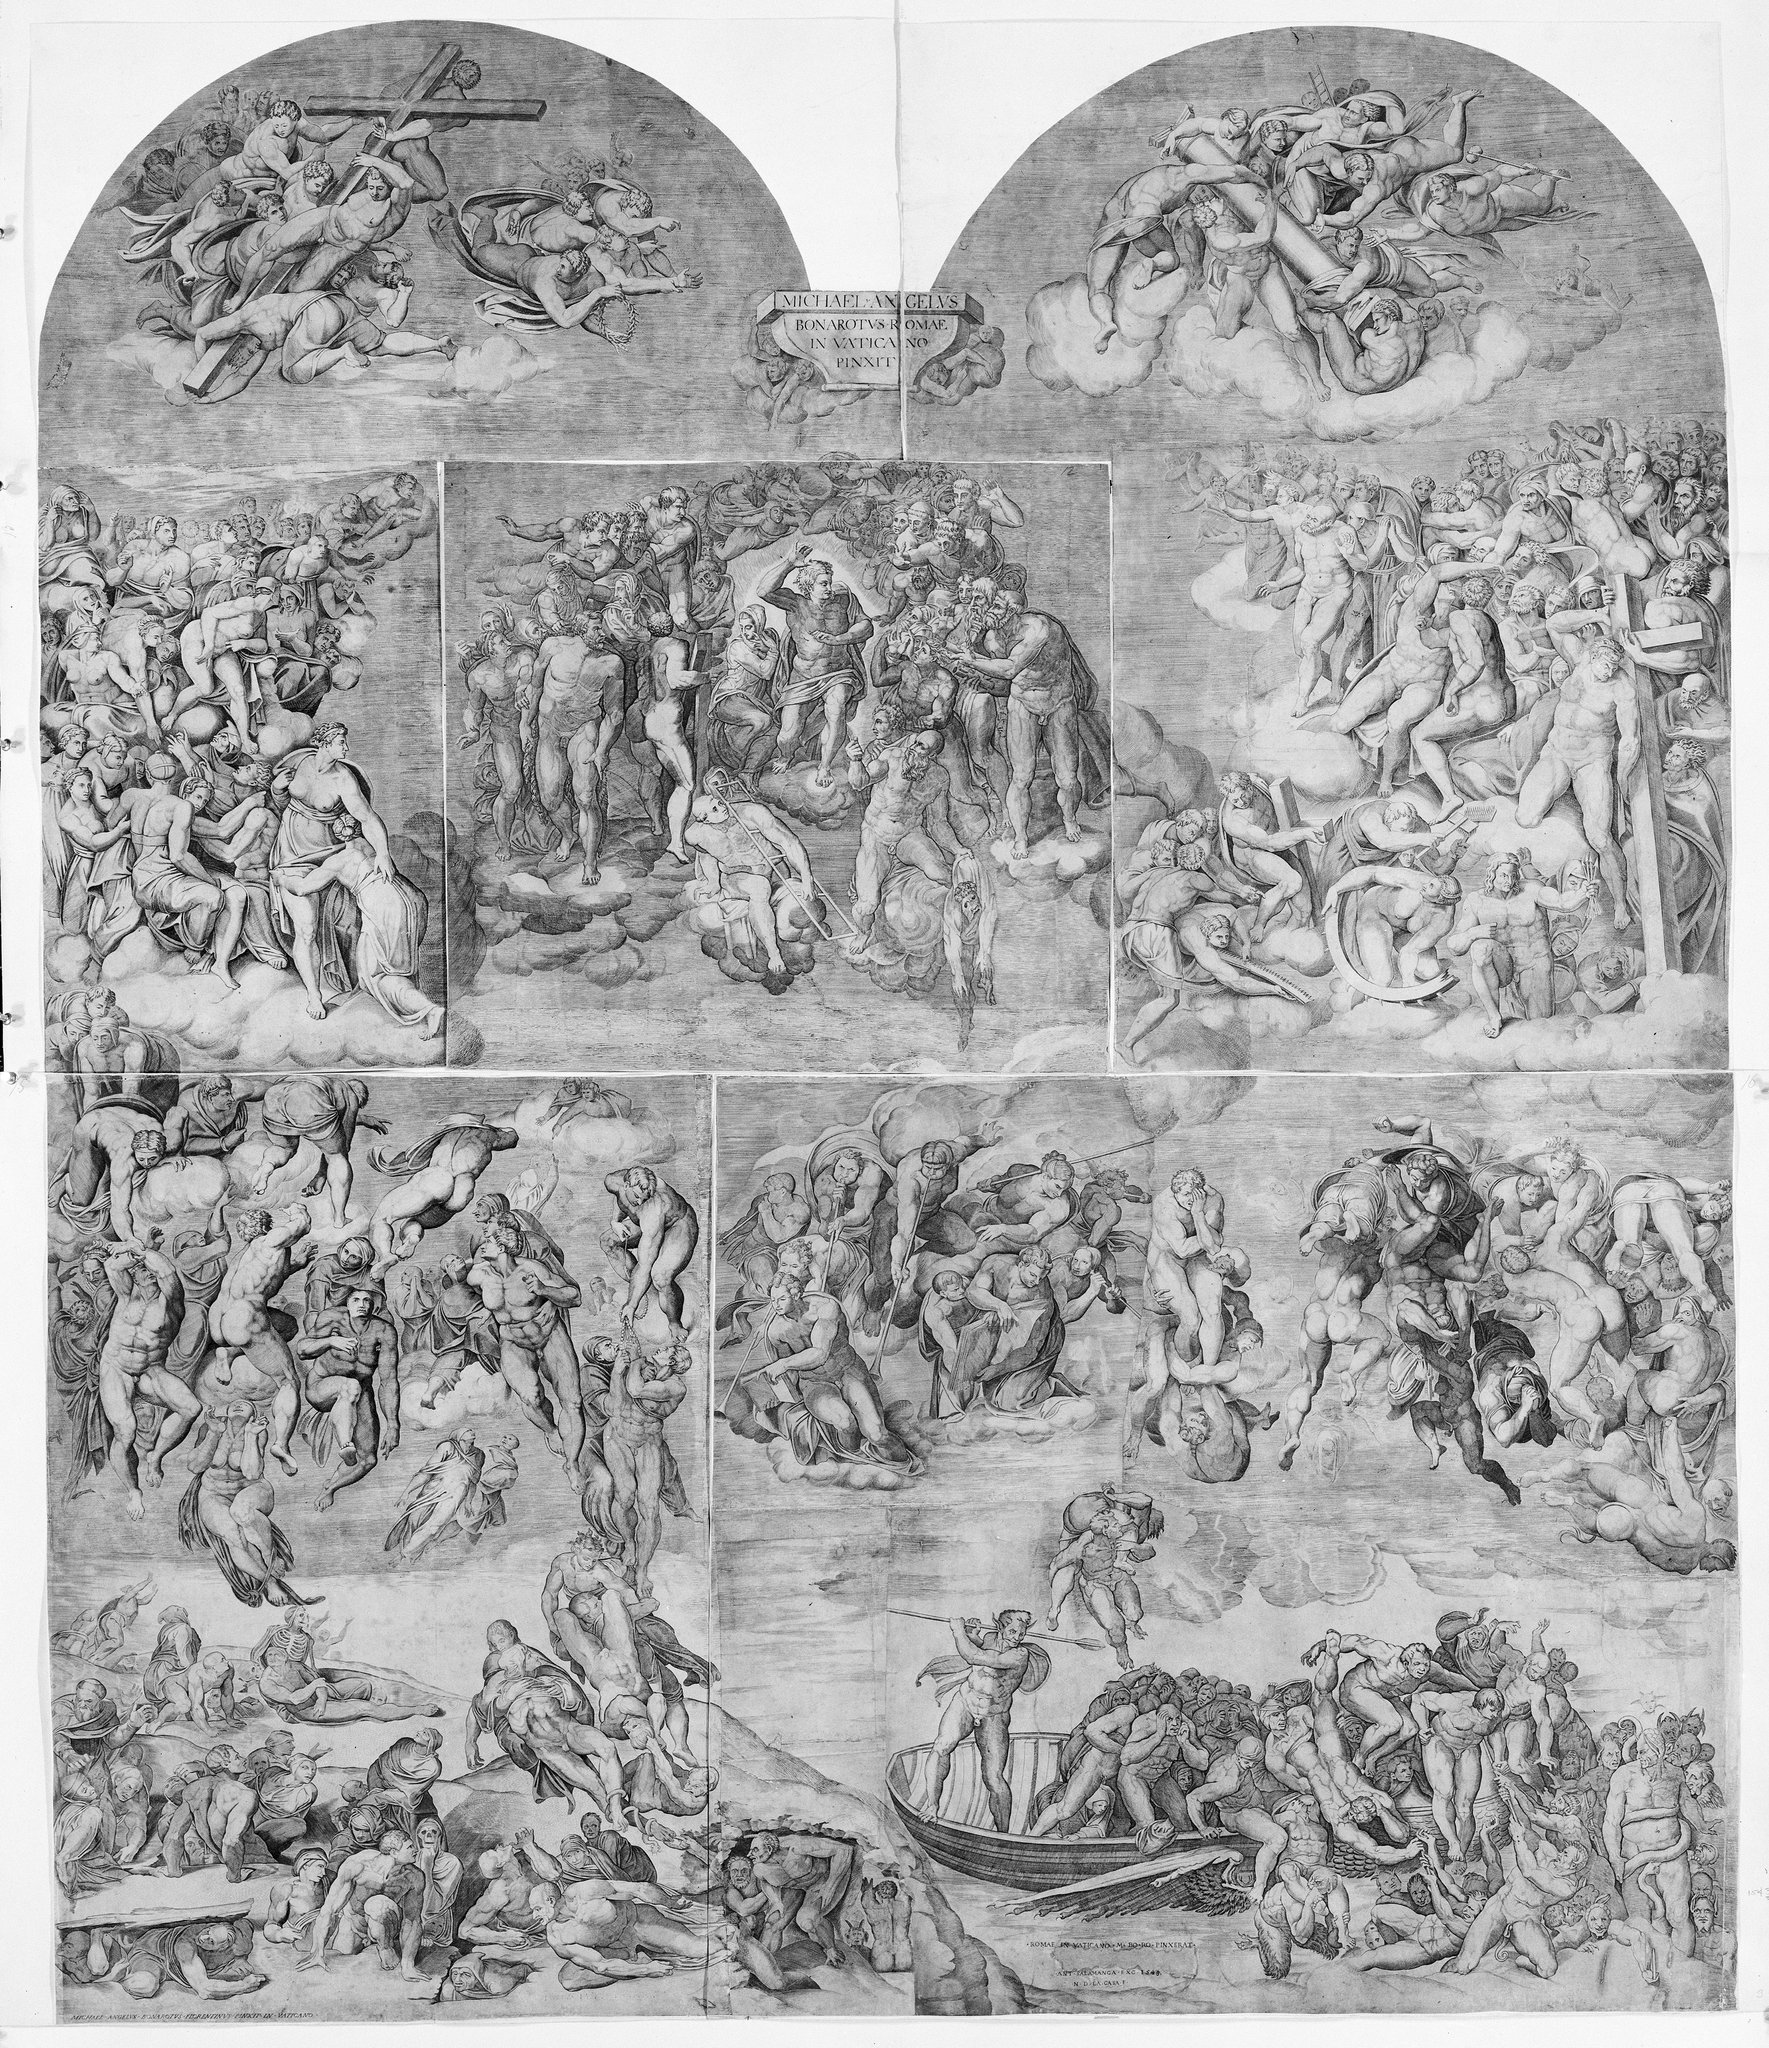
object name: print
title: Trumpeting Angels and Damned Souls Being Pulled Down by Devils (lower center and right section of the Last Judgment)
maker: niccolò della casa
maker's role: artist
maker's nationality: french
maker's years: 1543-1548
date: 1548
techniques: engraving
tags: male nudes,female nudes,angels,devil,last judgement